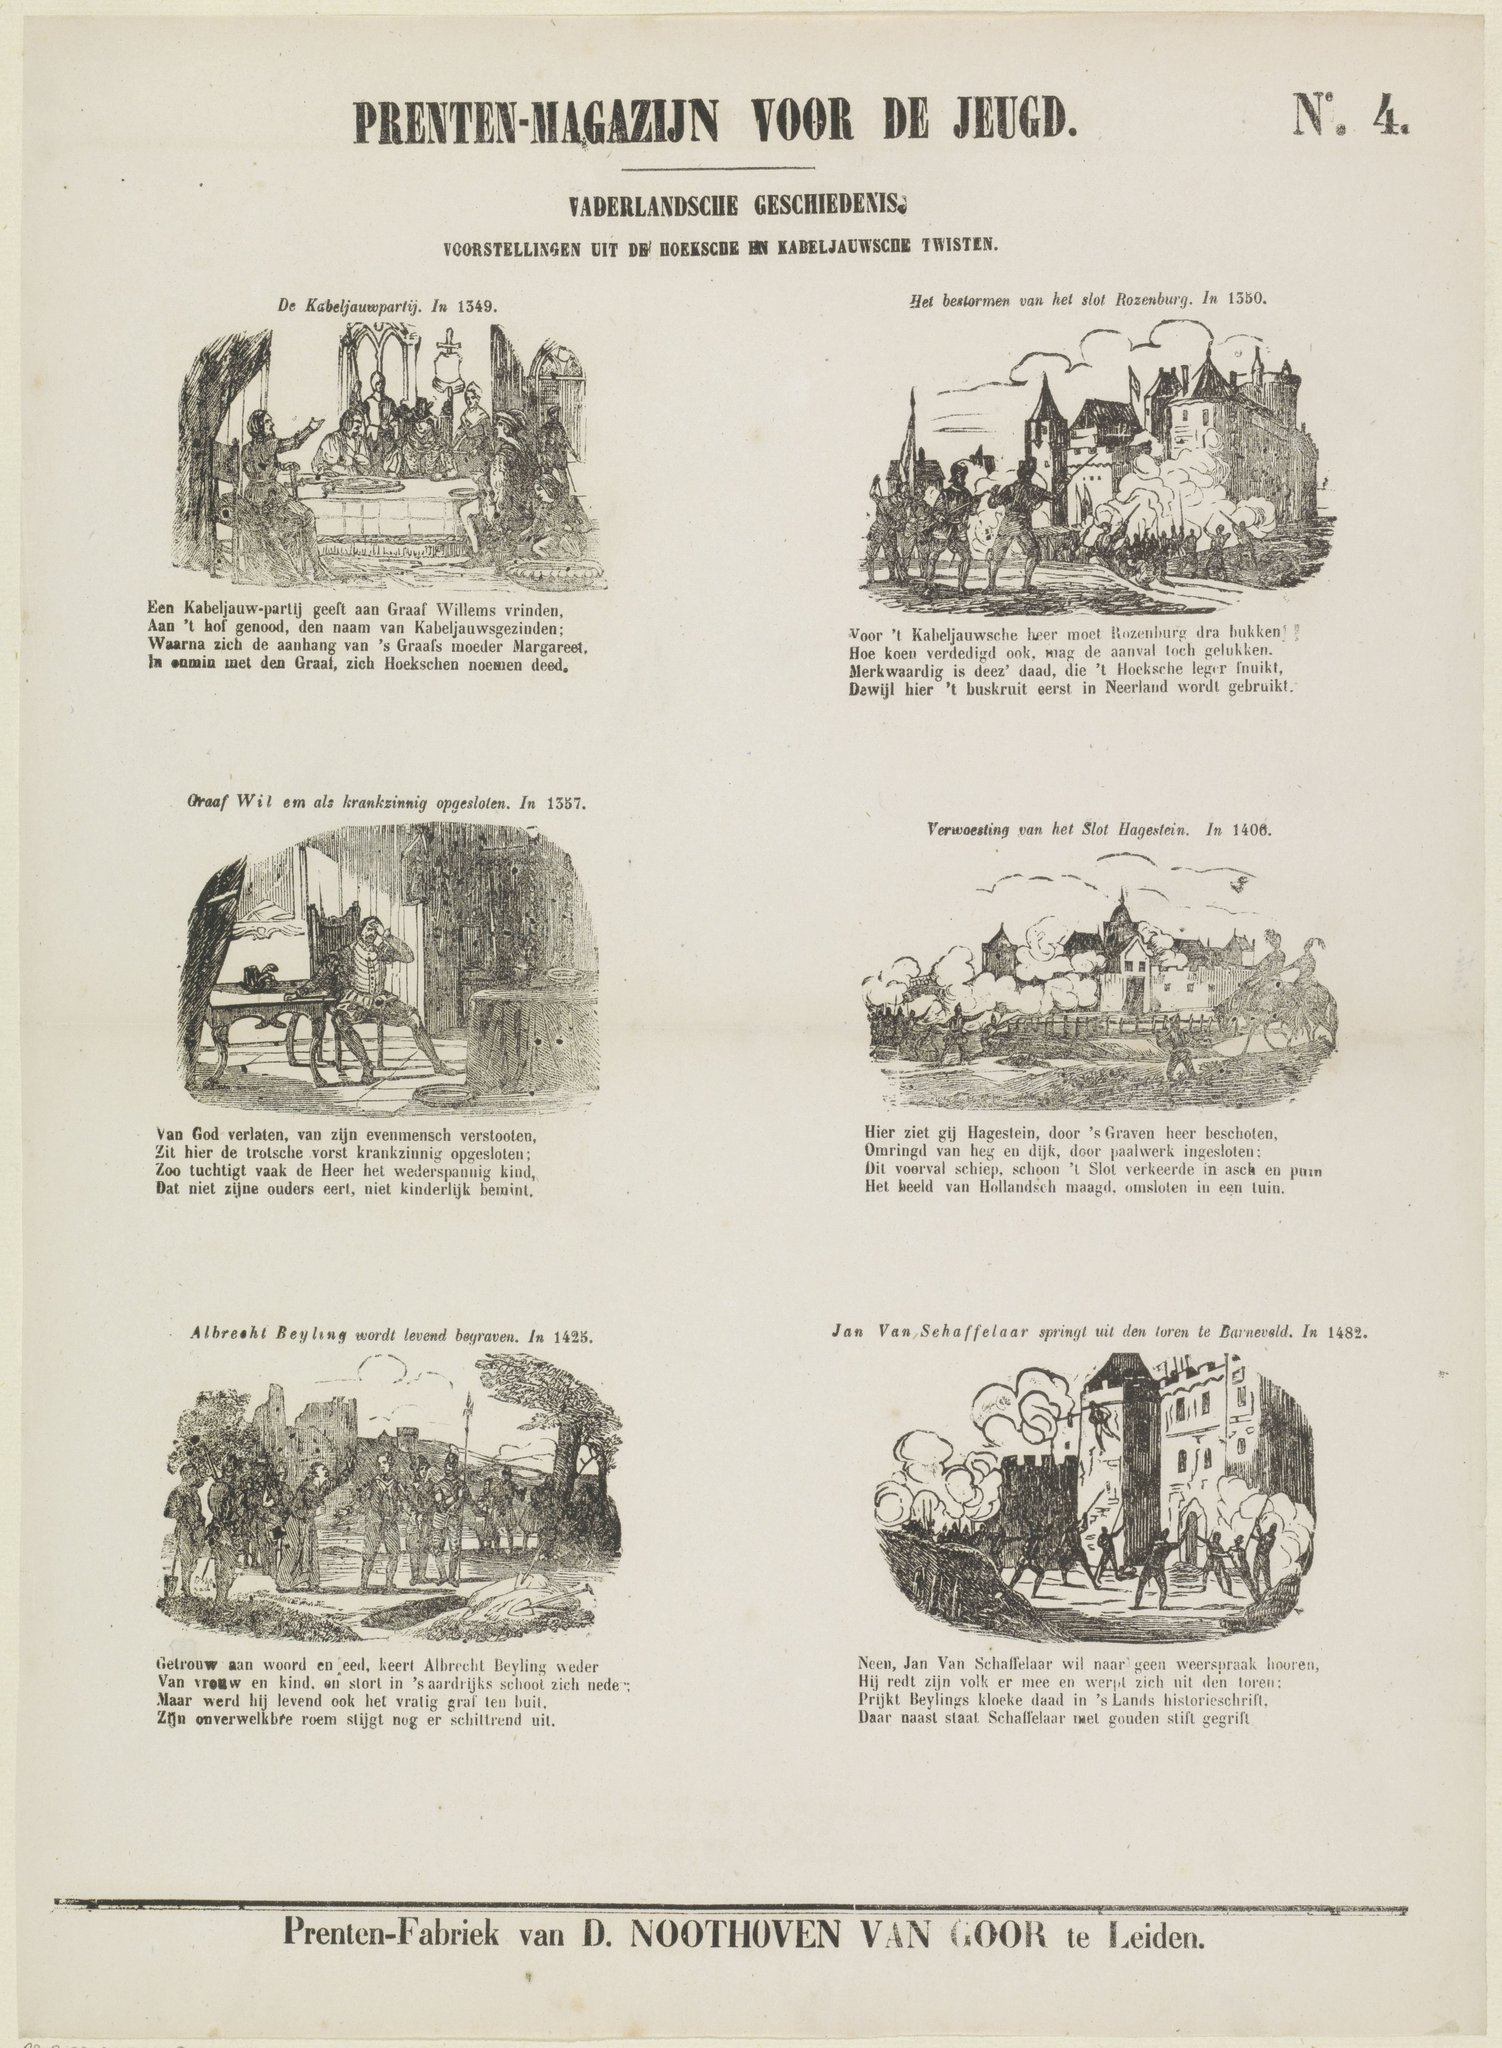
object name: popular print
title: Voorstellingen uit de Hoeksche en Kabeljaauwsche twisten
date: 1850-1881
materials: paper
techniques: letterpress printing, engraving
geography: leiden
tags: earl, willem v van holland (graaf van holland en zeeland), history, palace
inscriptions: collector's mark: Lugt 2760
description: Blad met 6 voorstellingen van de Hoekse en Kabeljauwse twisten, waaronder Graaf Willem die wordt opgesloten, de verwoesting van Slot Hagestein en Jan Schaffelaar die uit de toren te Barneveld springt. Boven elke voorstelling een titel en jaartal en onder elke voorstelling een vierregelig vers. Genummerd rechtsboven: No. 4.